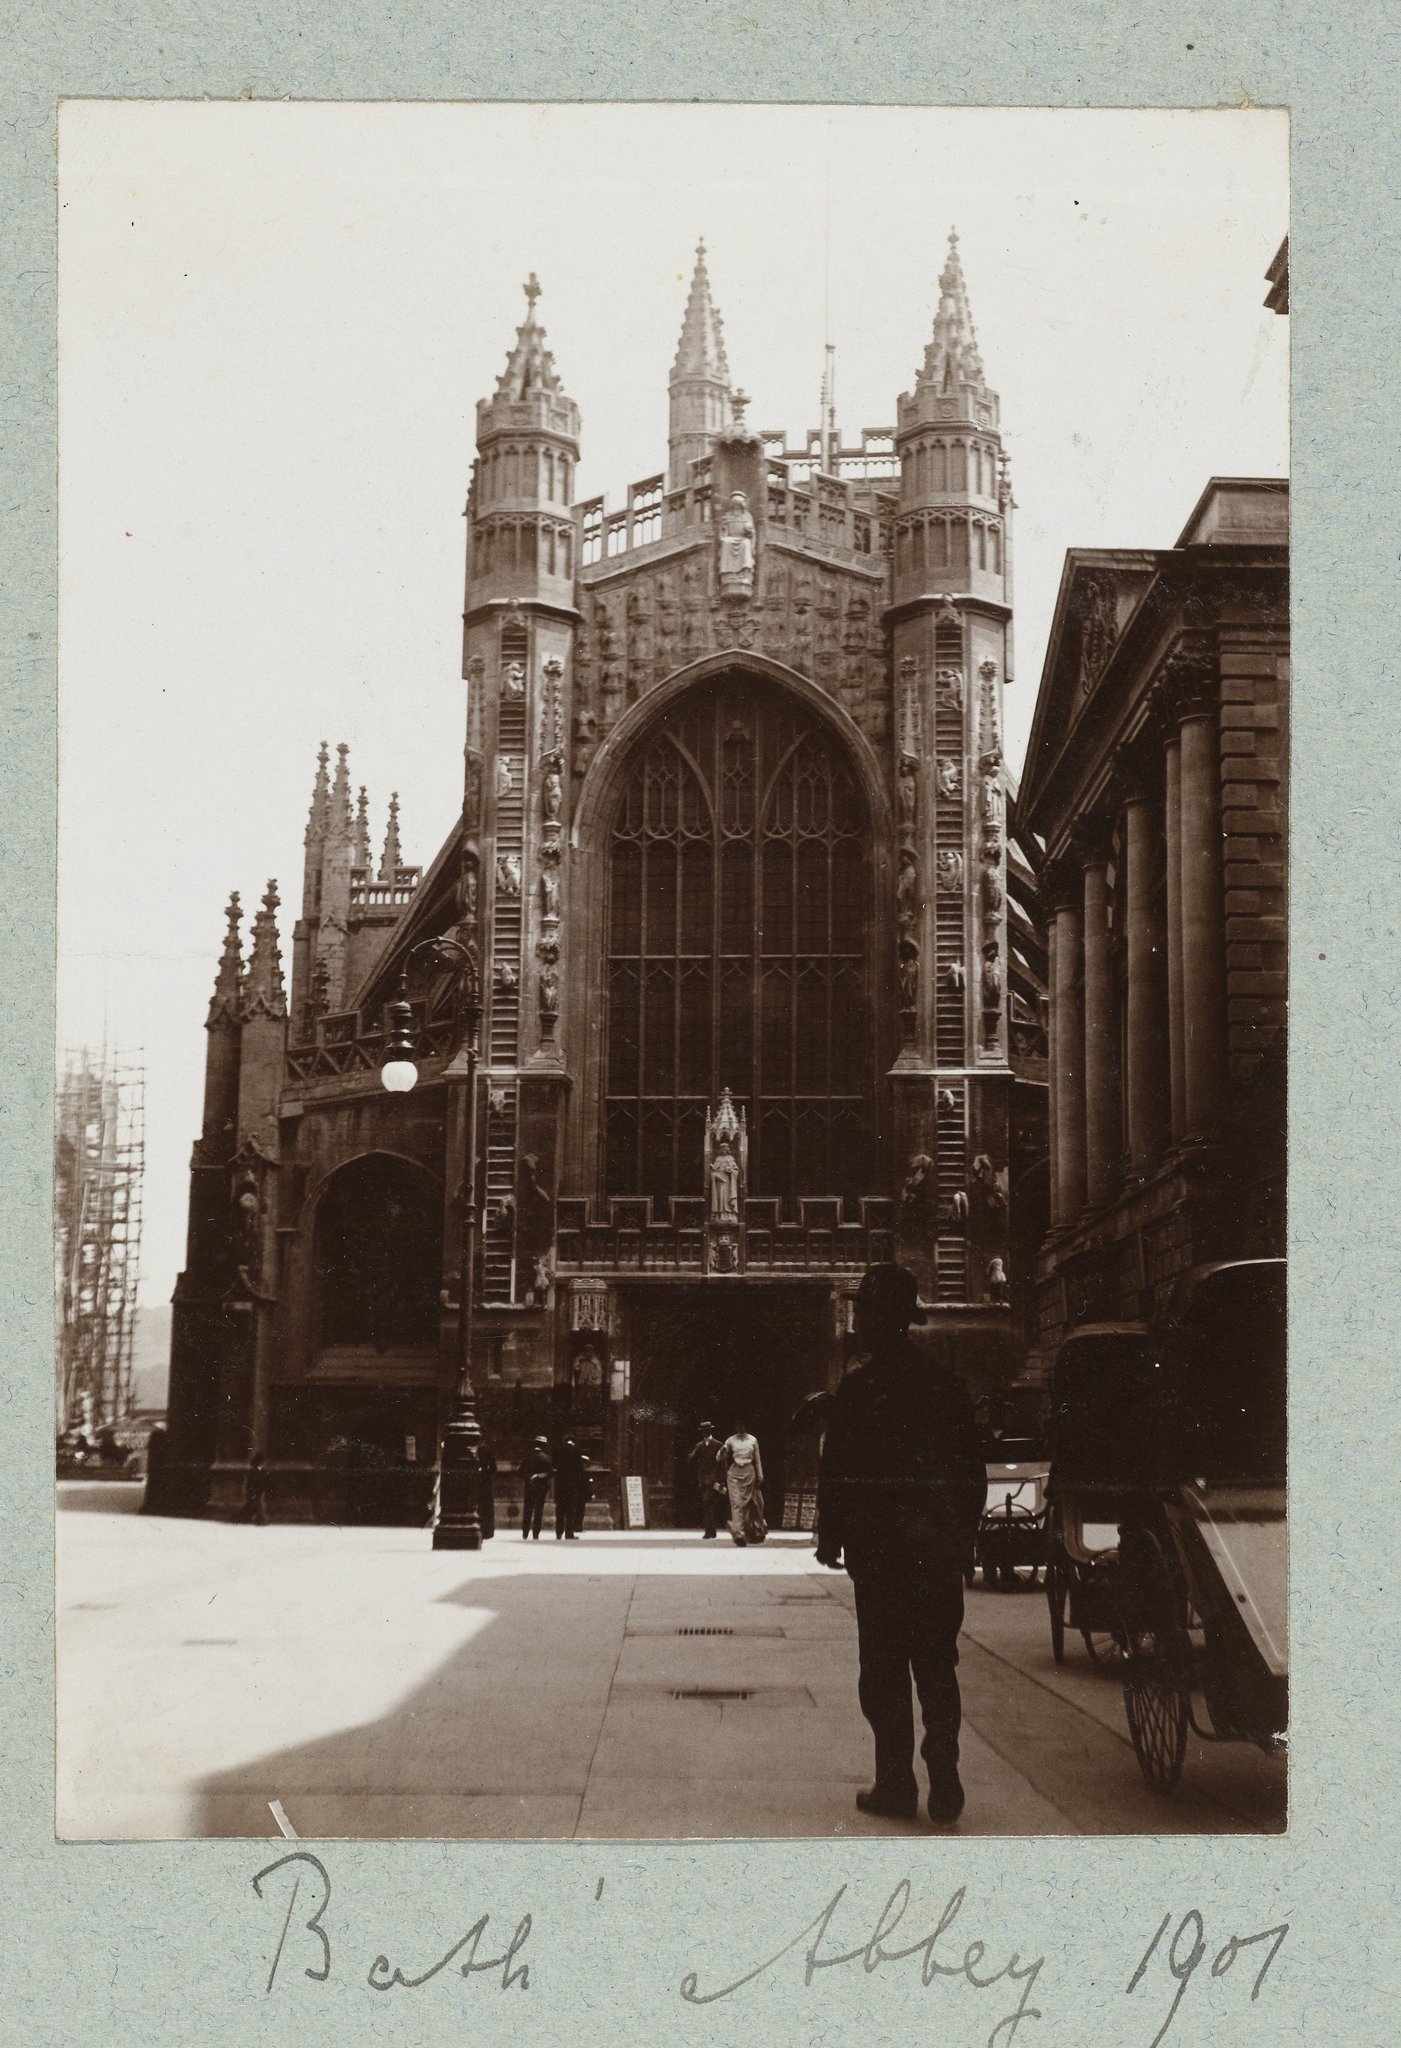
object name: photograph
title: Bath' Abbey 1901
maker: frits freerks fontein fz.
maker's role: fotograaf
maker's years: 1882-1928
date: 1901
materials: cardboard, paper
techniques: gelatin silver print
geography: netherlands